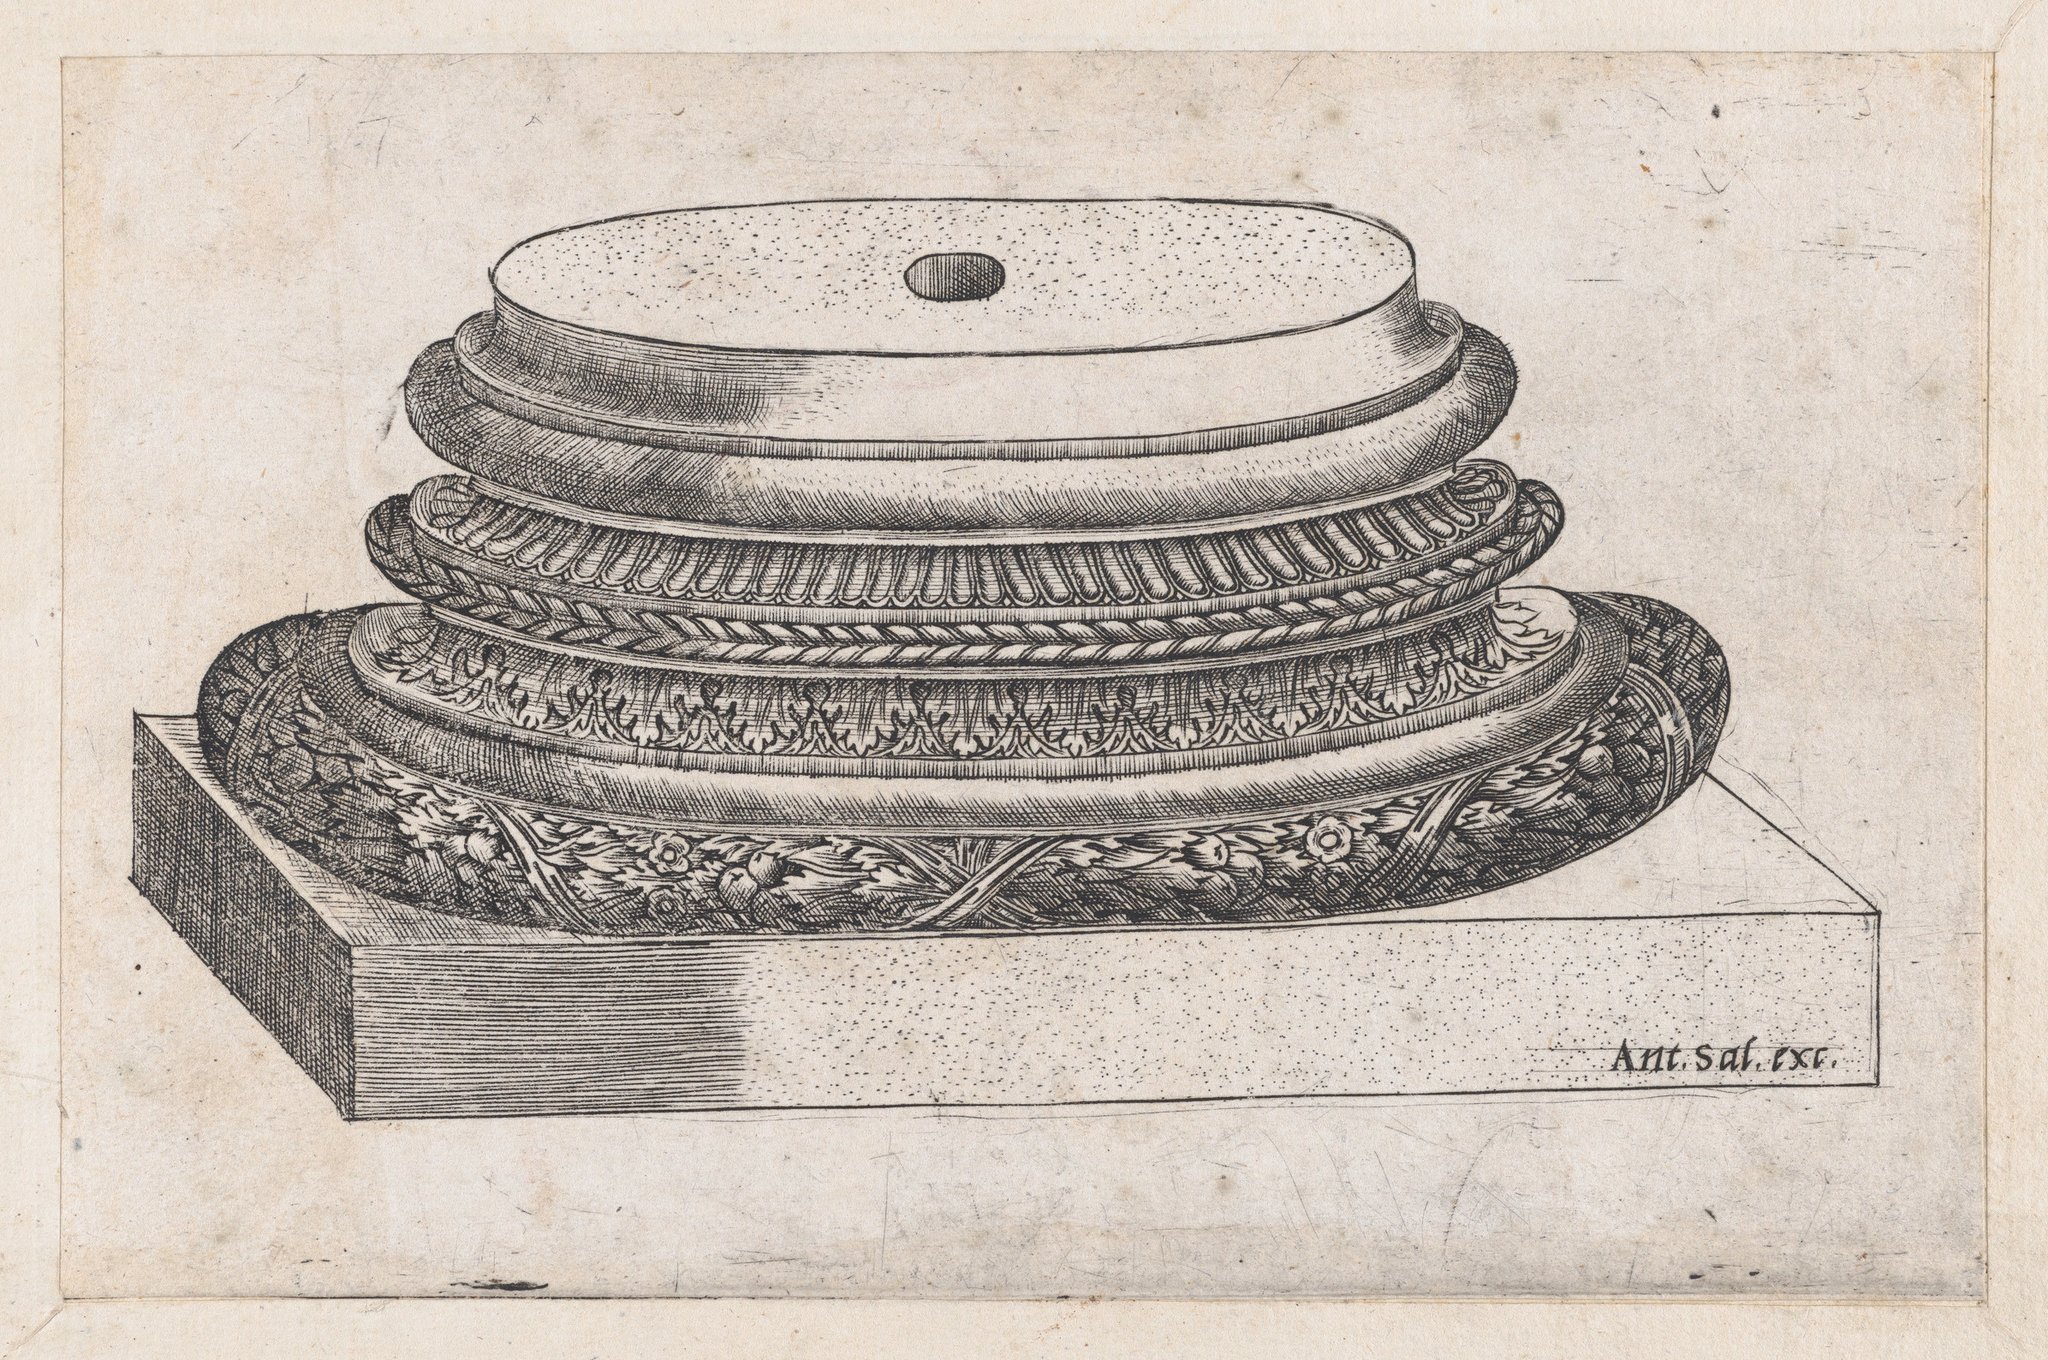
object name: print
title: Decorated base, from "Speculum Romanae Magnificentiae"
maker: monogrammist g.a. with the caltrop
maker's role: artist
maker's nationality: italian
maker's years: 1535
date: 1537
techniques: engraving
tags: architecture